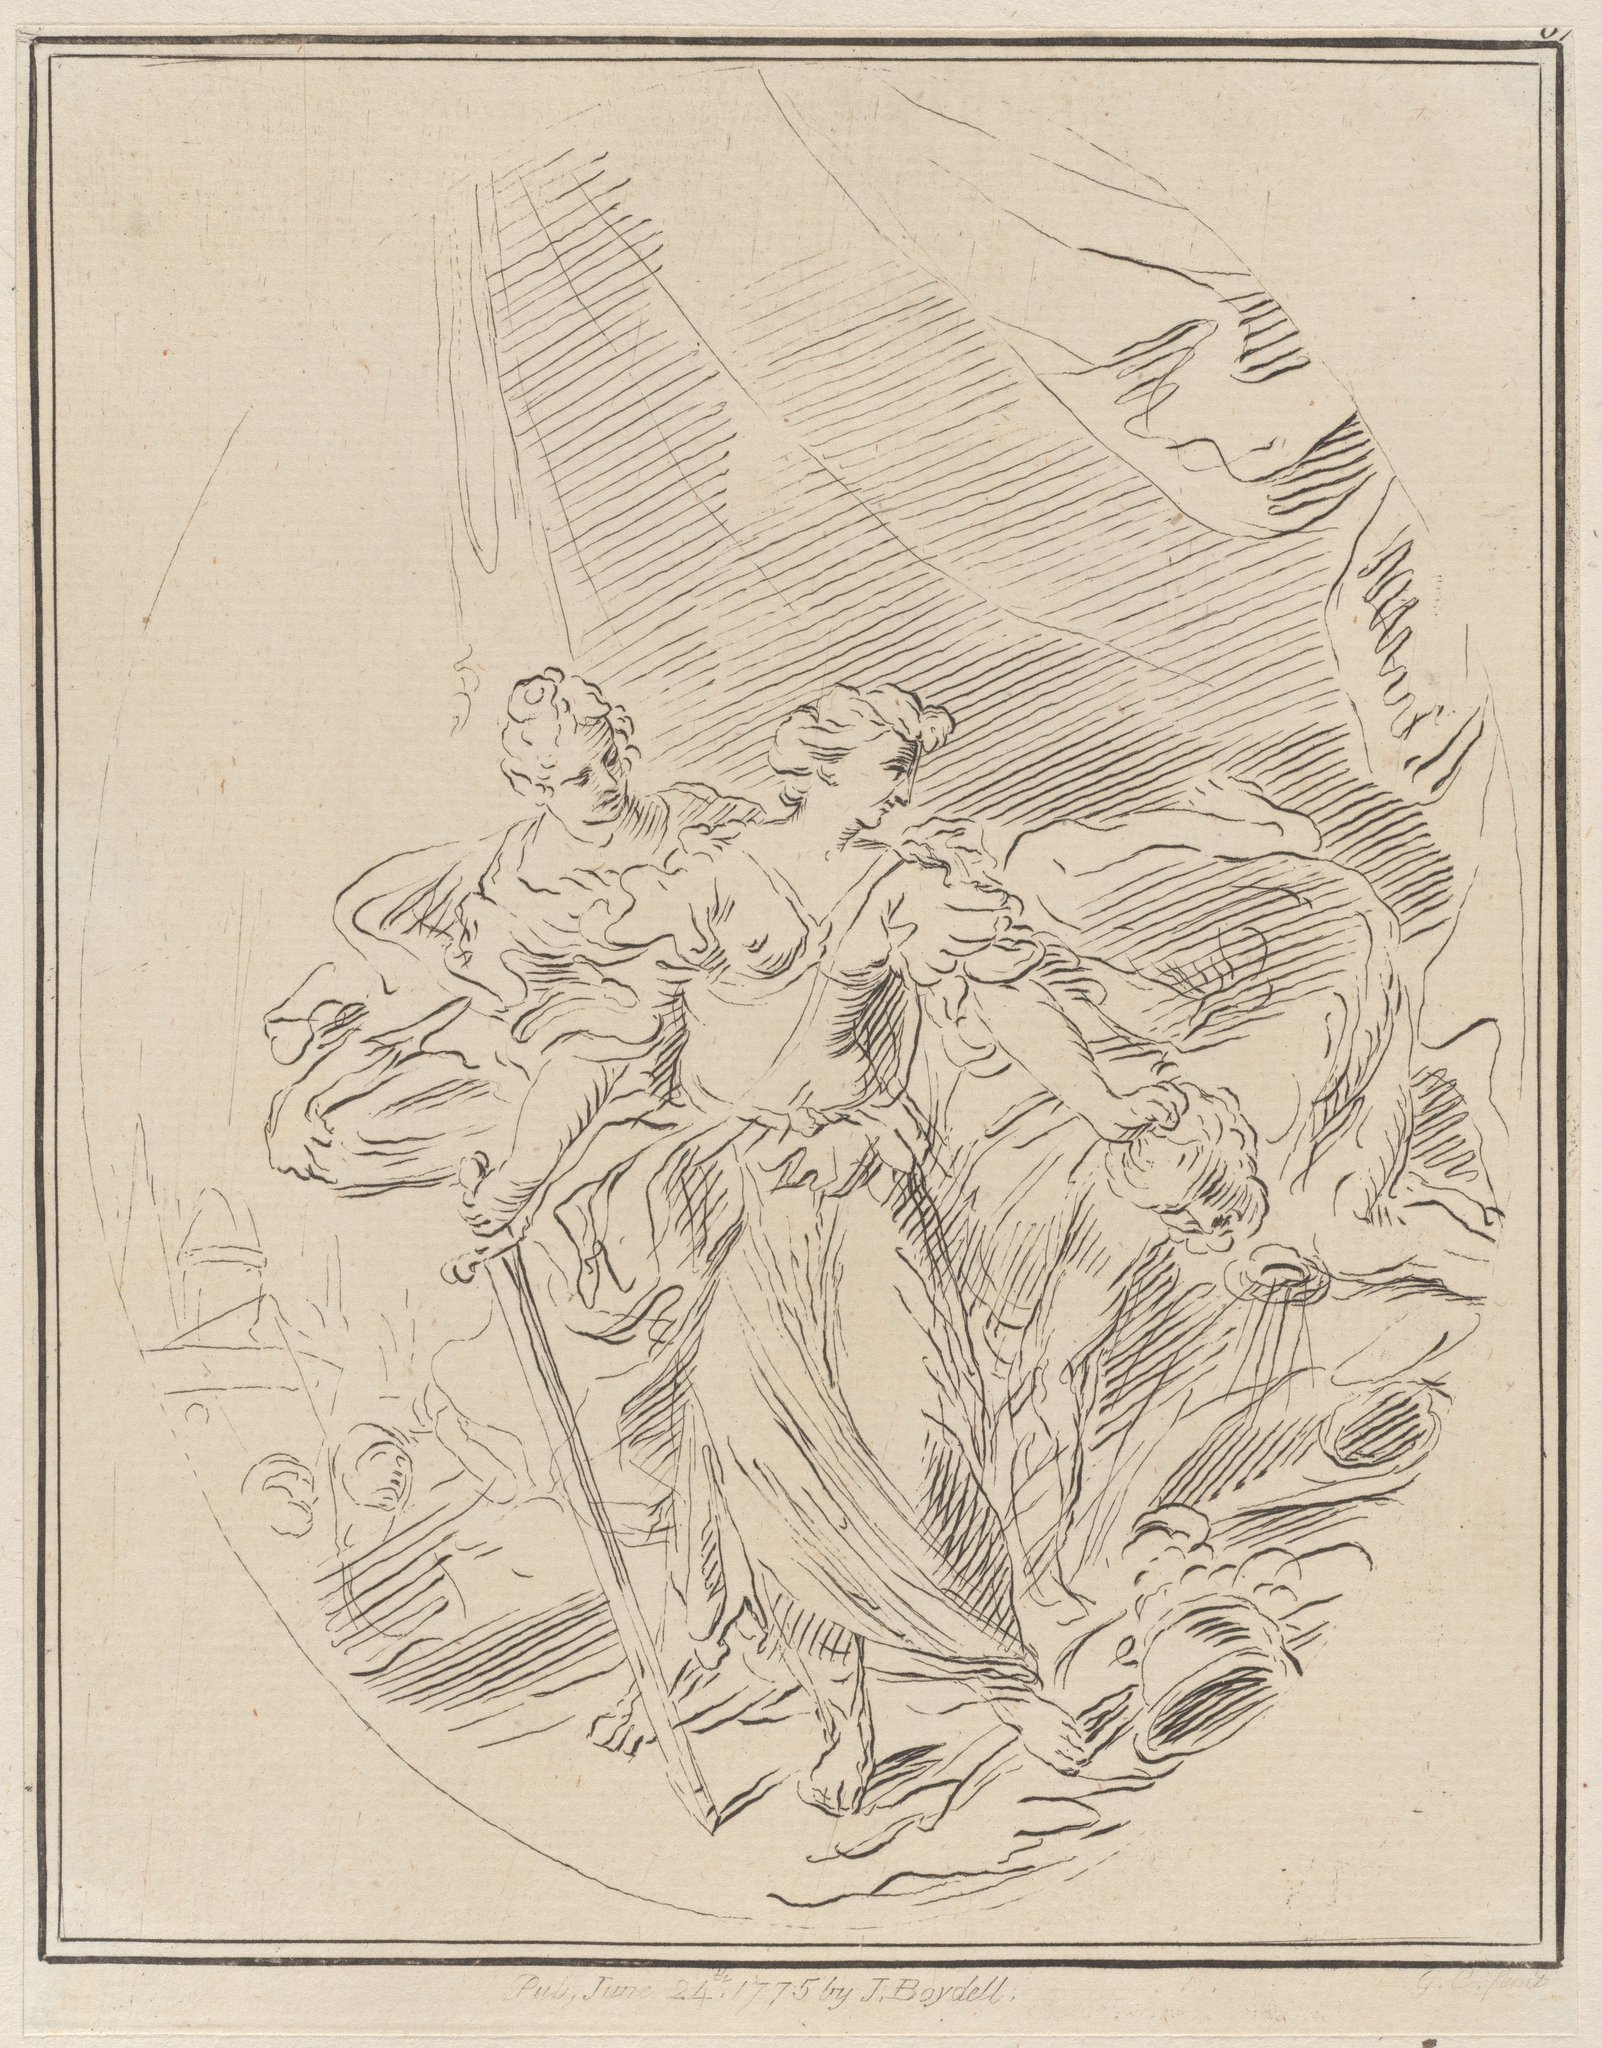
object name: print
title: Judith slaying Holofernes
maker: giuseppe canale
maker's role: artist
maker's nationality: italian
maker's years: 1725-1802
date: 1775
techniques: etching